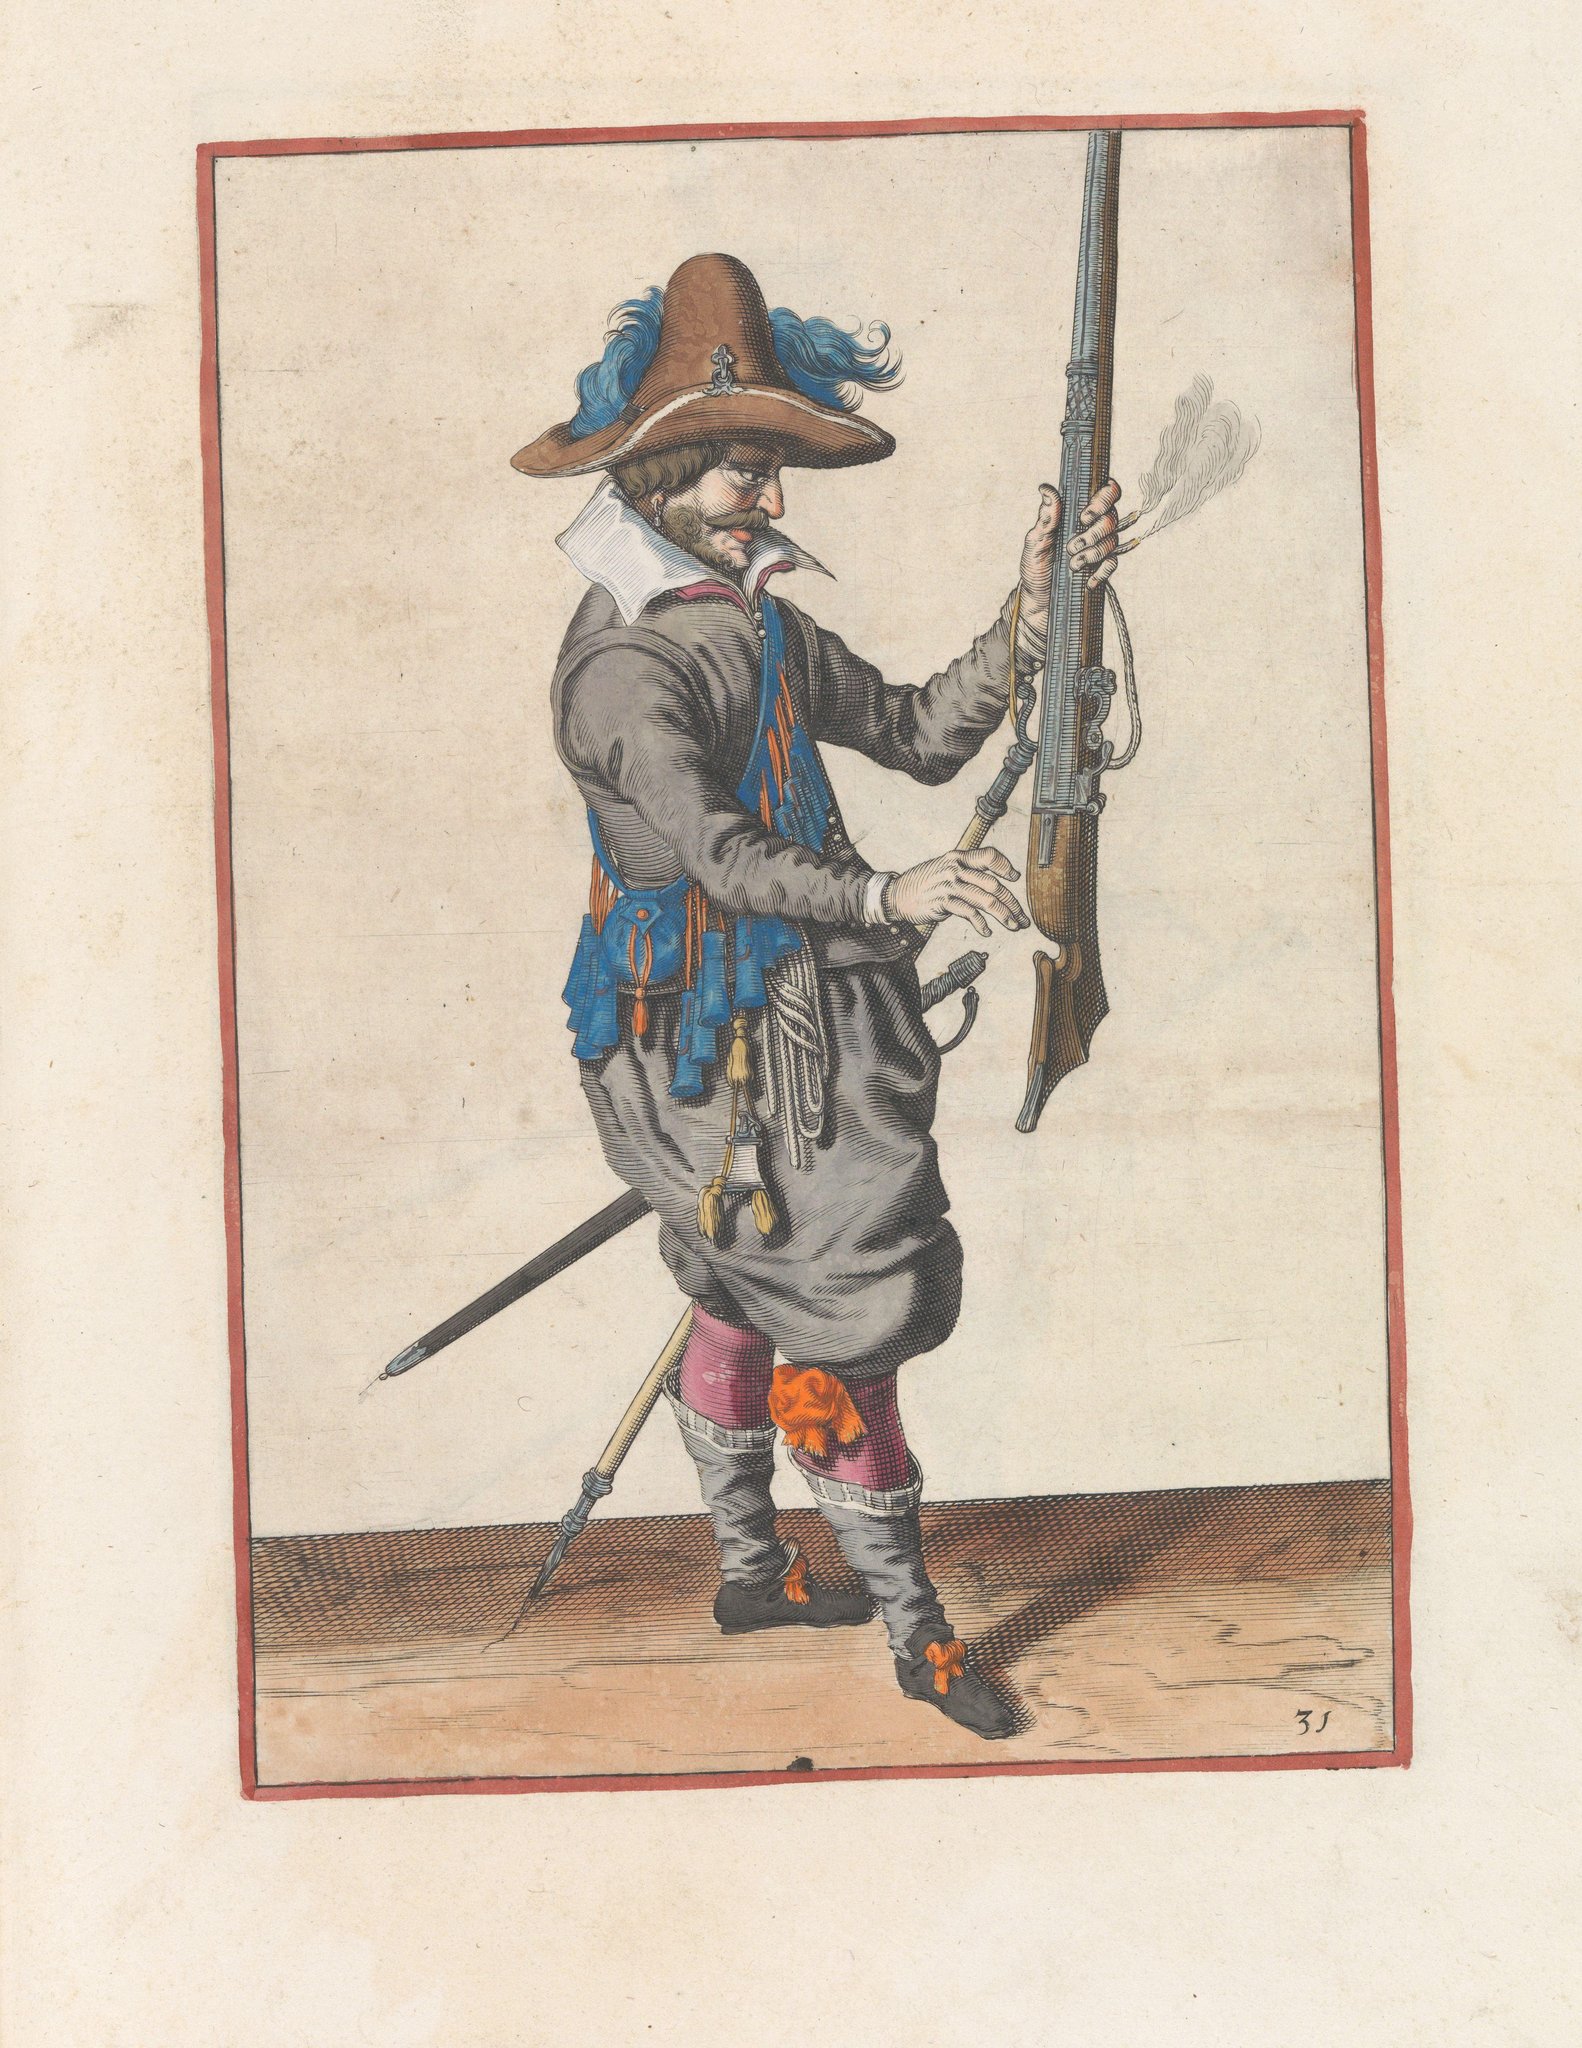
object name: print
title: Soldaat die zijn musket met zijn linkerhand rechtop vasthoudt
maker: jacques de gheyn (ii)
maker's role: painter, print maker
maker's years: 1565-1629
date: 1597-1607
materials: paper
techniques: engraving, hand coloring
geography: the hague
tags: handling of weapons ~ military training, firearms: rifle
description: Een soldaat, ten voeten uit, naar rechts, die een musket (een bepaald type vuurwapen) met zijn linkerhand vasthoudt, de loop omhoog wijzend, alvorens het wapen over te brengen naar zijn rechterhand. In zijn linkerhand behalve het musket ook een brandende lont; aan zijn linkerpols een furket (musketvork). Deze prent is onderdeel van de reeks van 43 met de hand genummerde prenten van musketiers in de Wapenhandelinghe. Dit exemplaar met het nummer gedrukt.